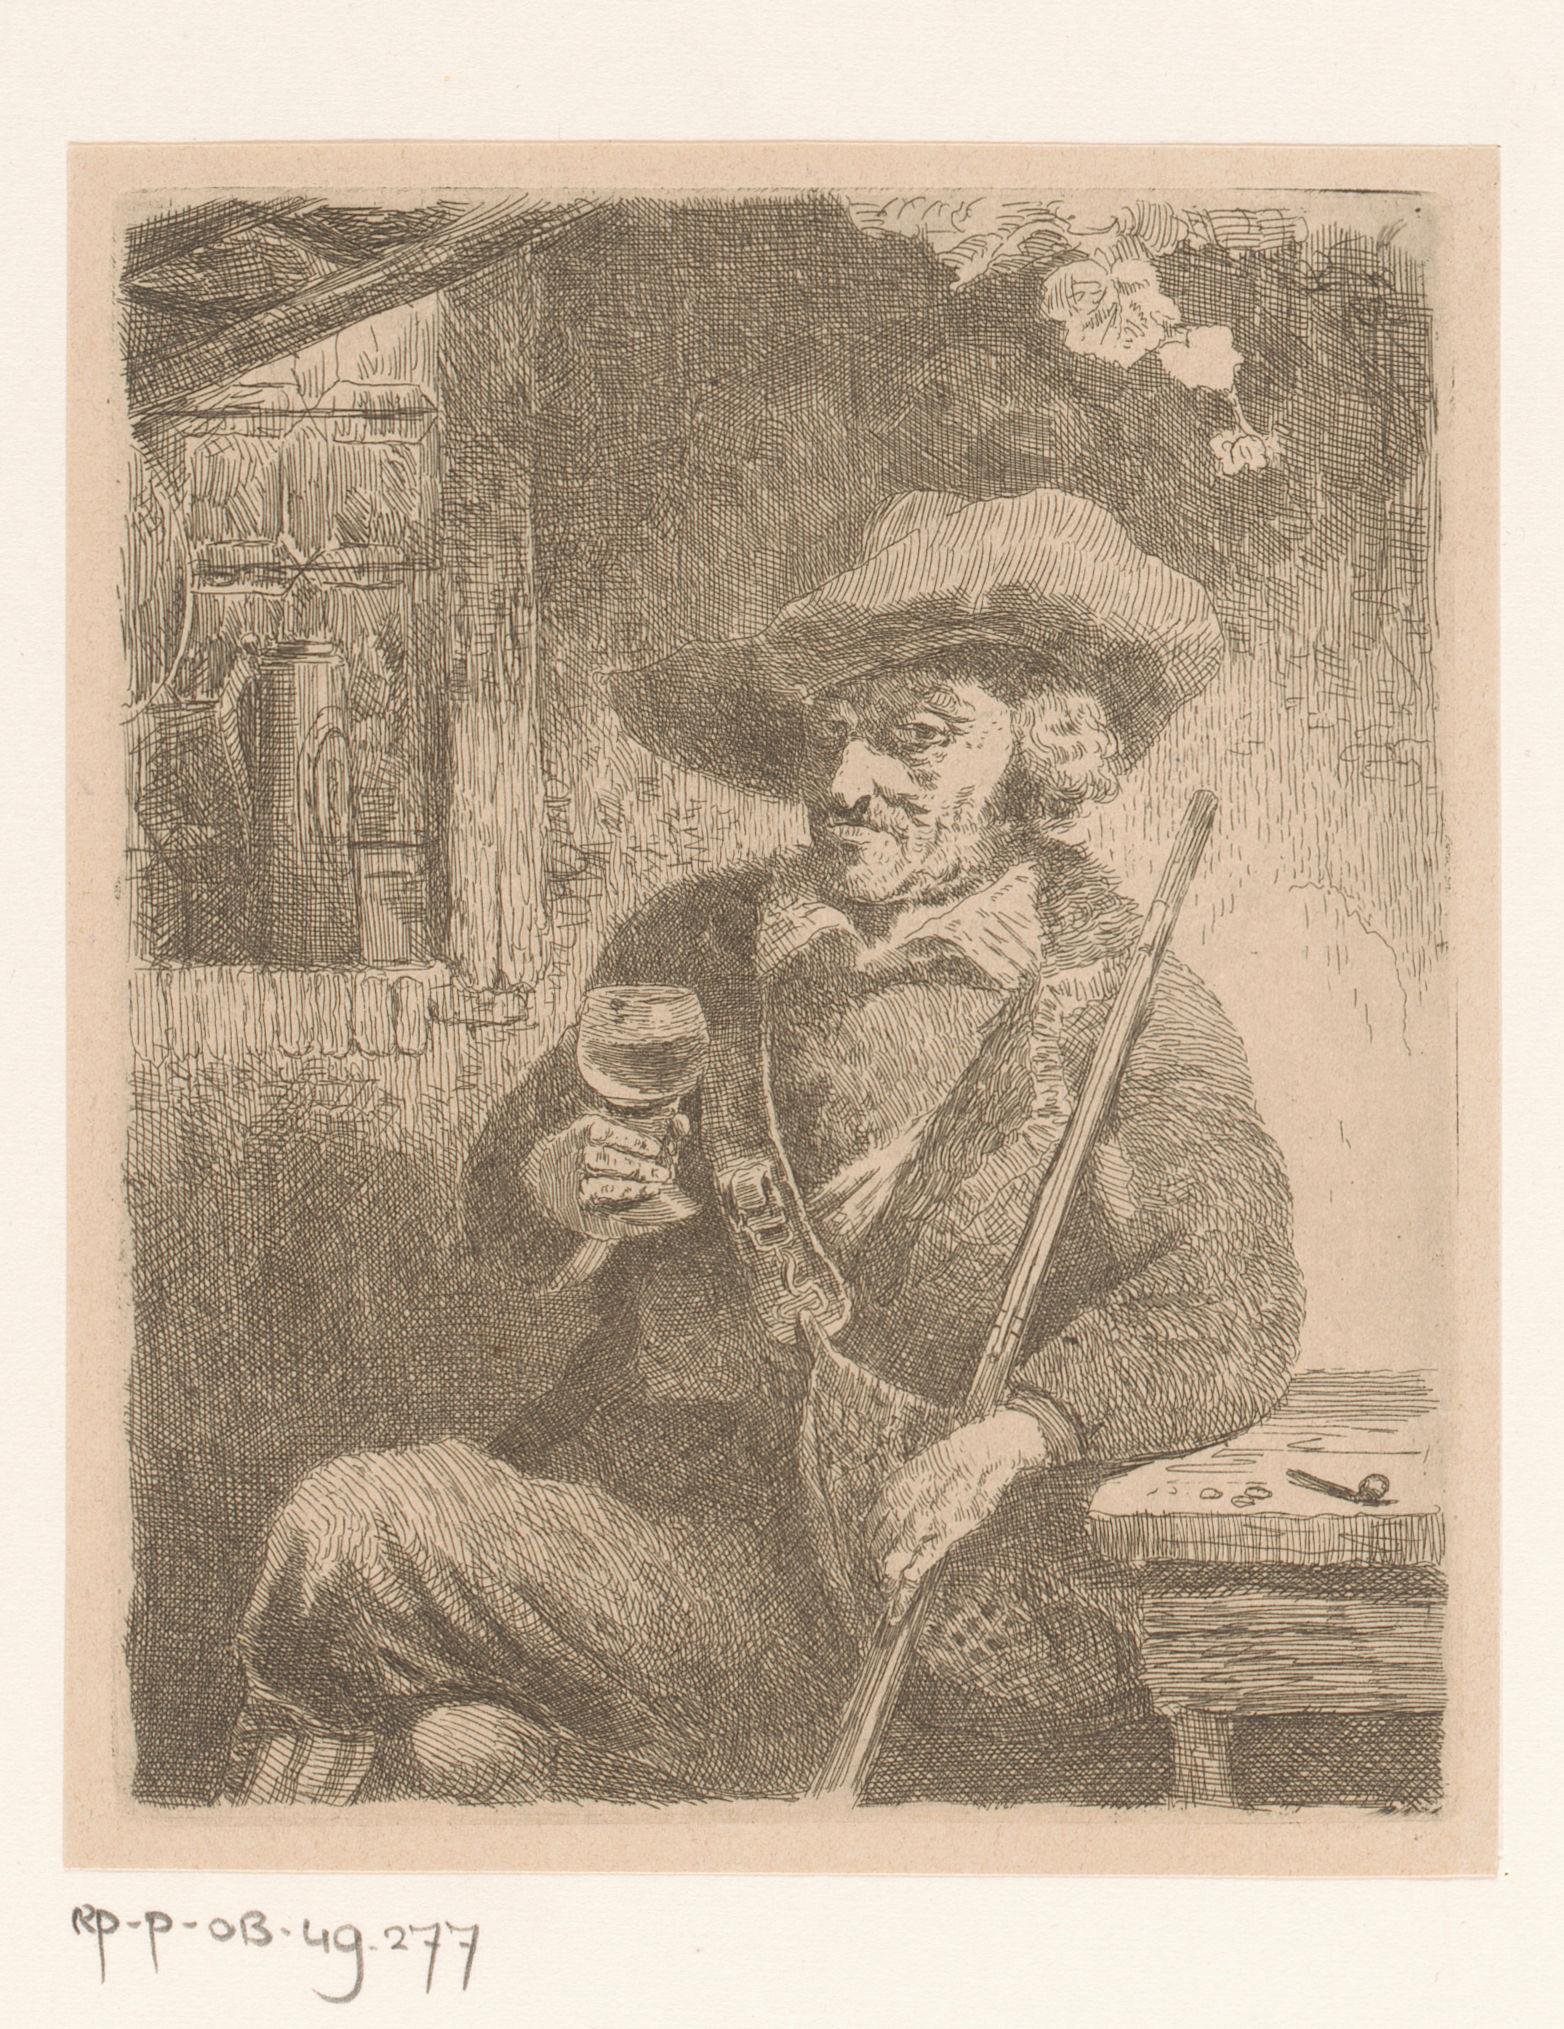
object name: print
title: Jager drinkt een glas wijn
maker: willem linnig (i)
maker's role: print maker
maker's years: 1819-1885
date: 1829-1885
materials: paper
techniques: etching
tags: hunter, glass of wine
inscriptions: collector's mark: Lugt 2228